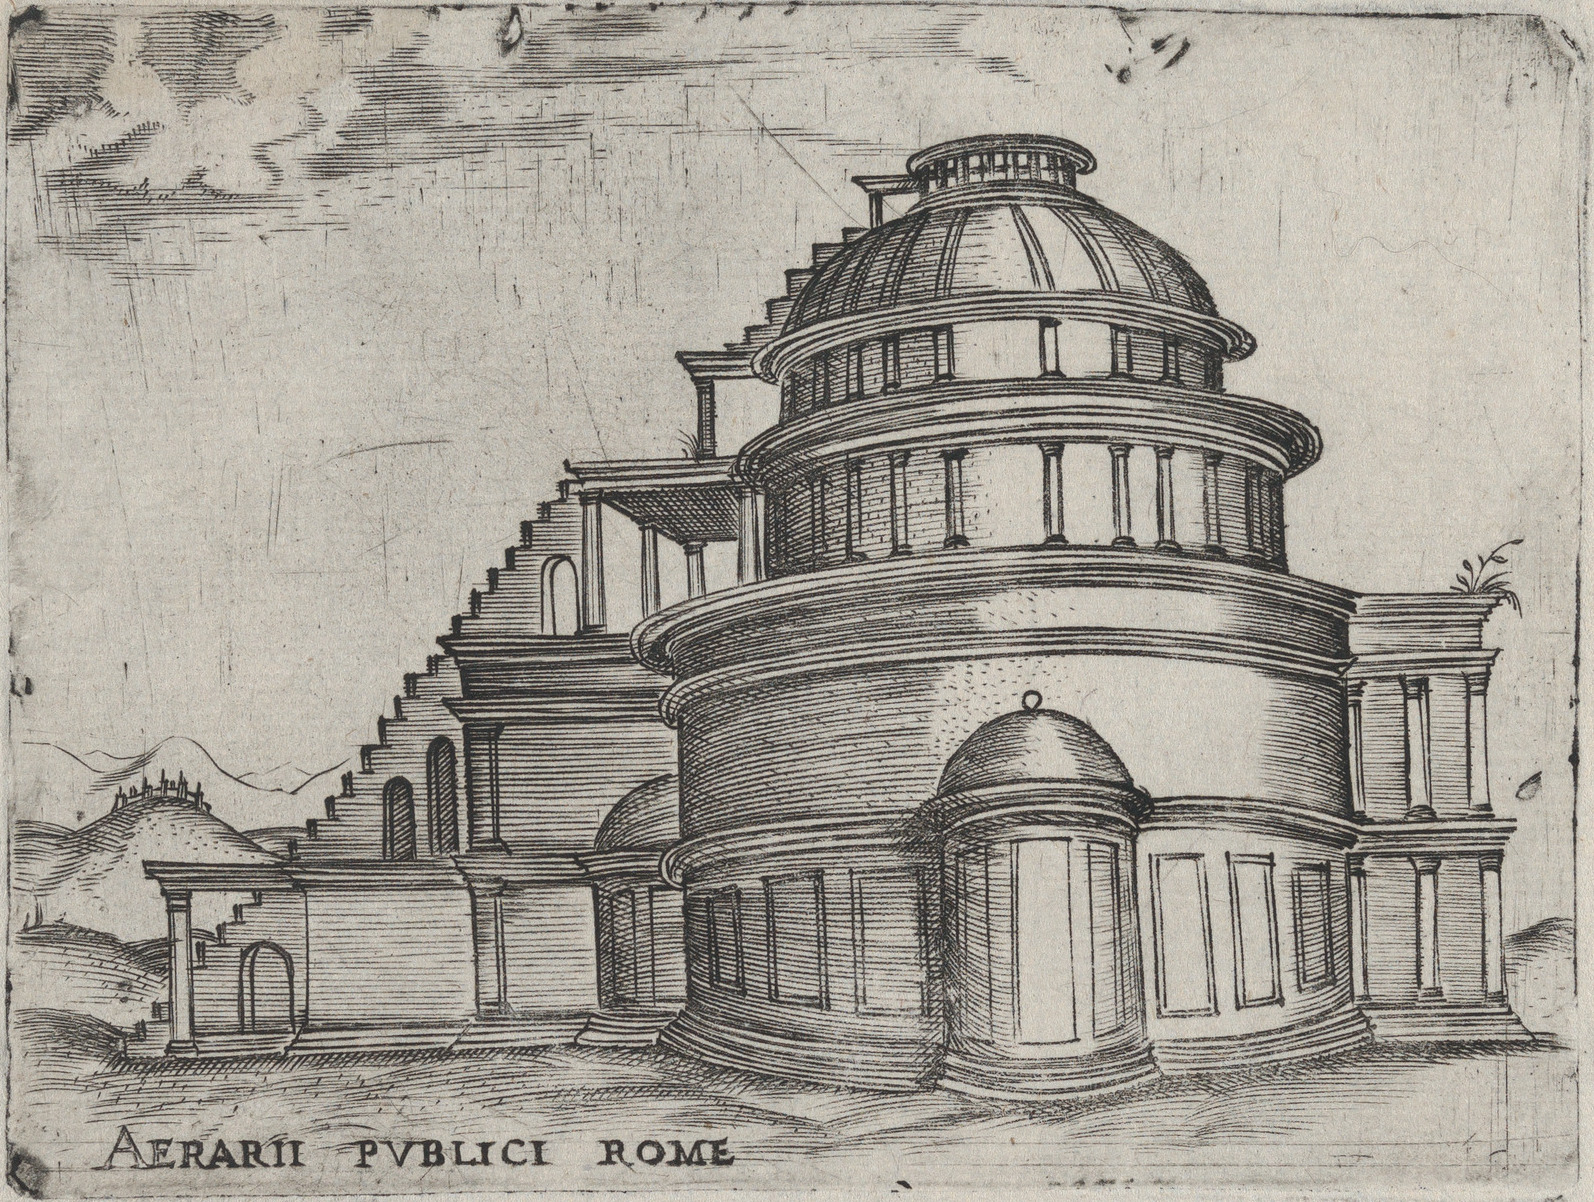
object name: print ornament architecture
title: Aerarii Publici Rome, from a Series of 24 Depicting (Reconstructed) Buildings from Roman Antiquity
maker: anonymous, italian, 16th century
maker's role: artist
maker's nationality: italian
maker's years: 1500-1600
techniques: engraving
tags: architecture,buildings